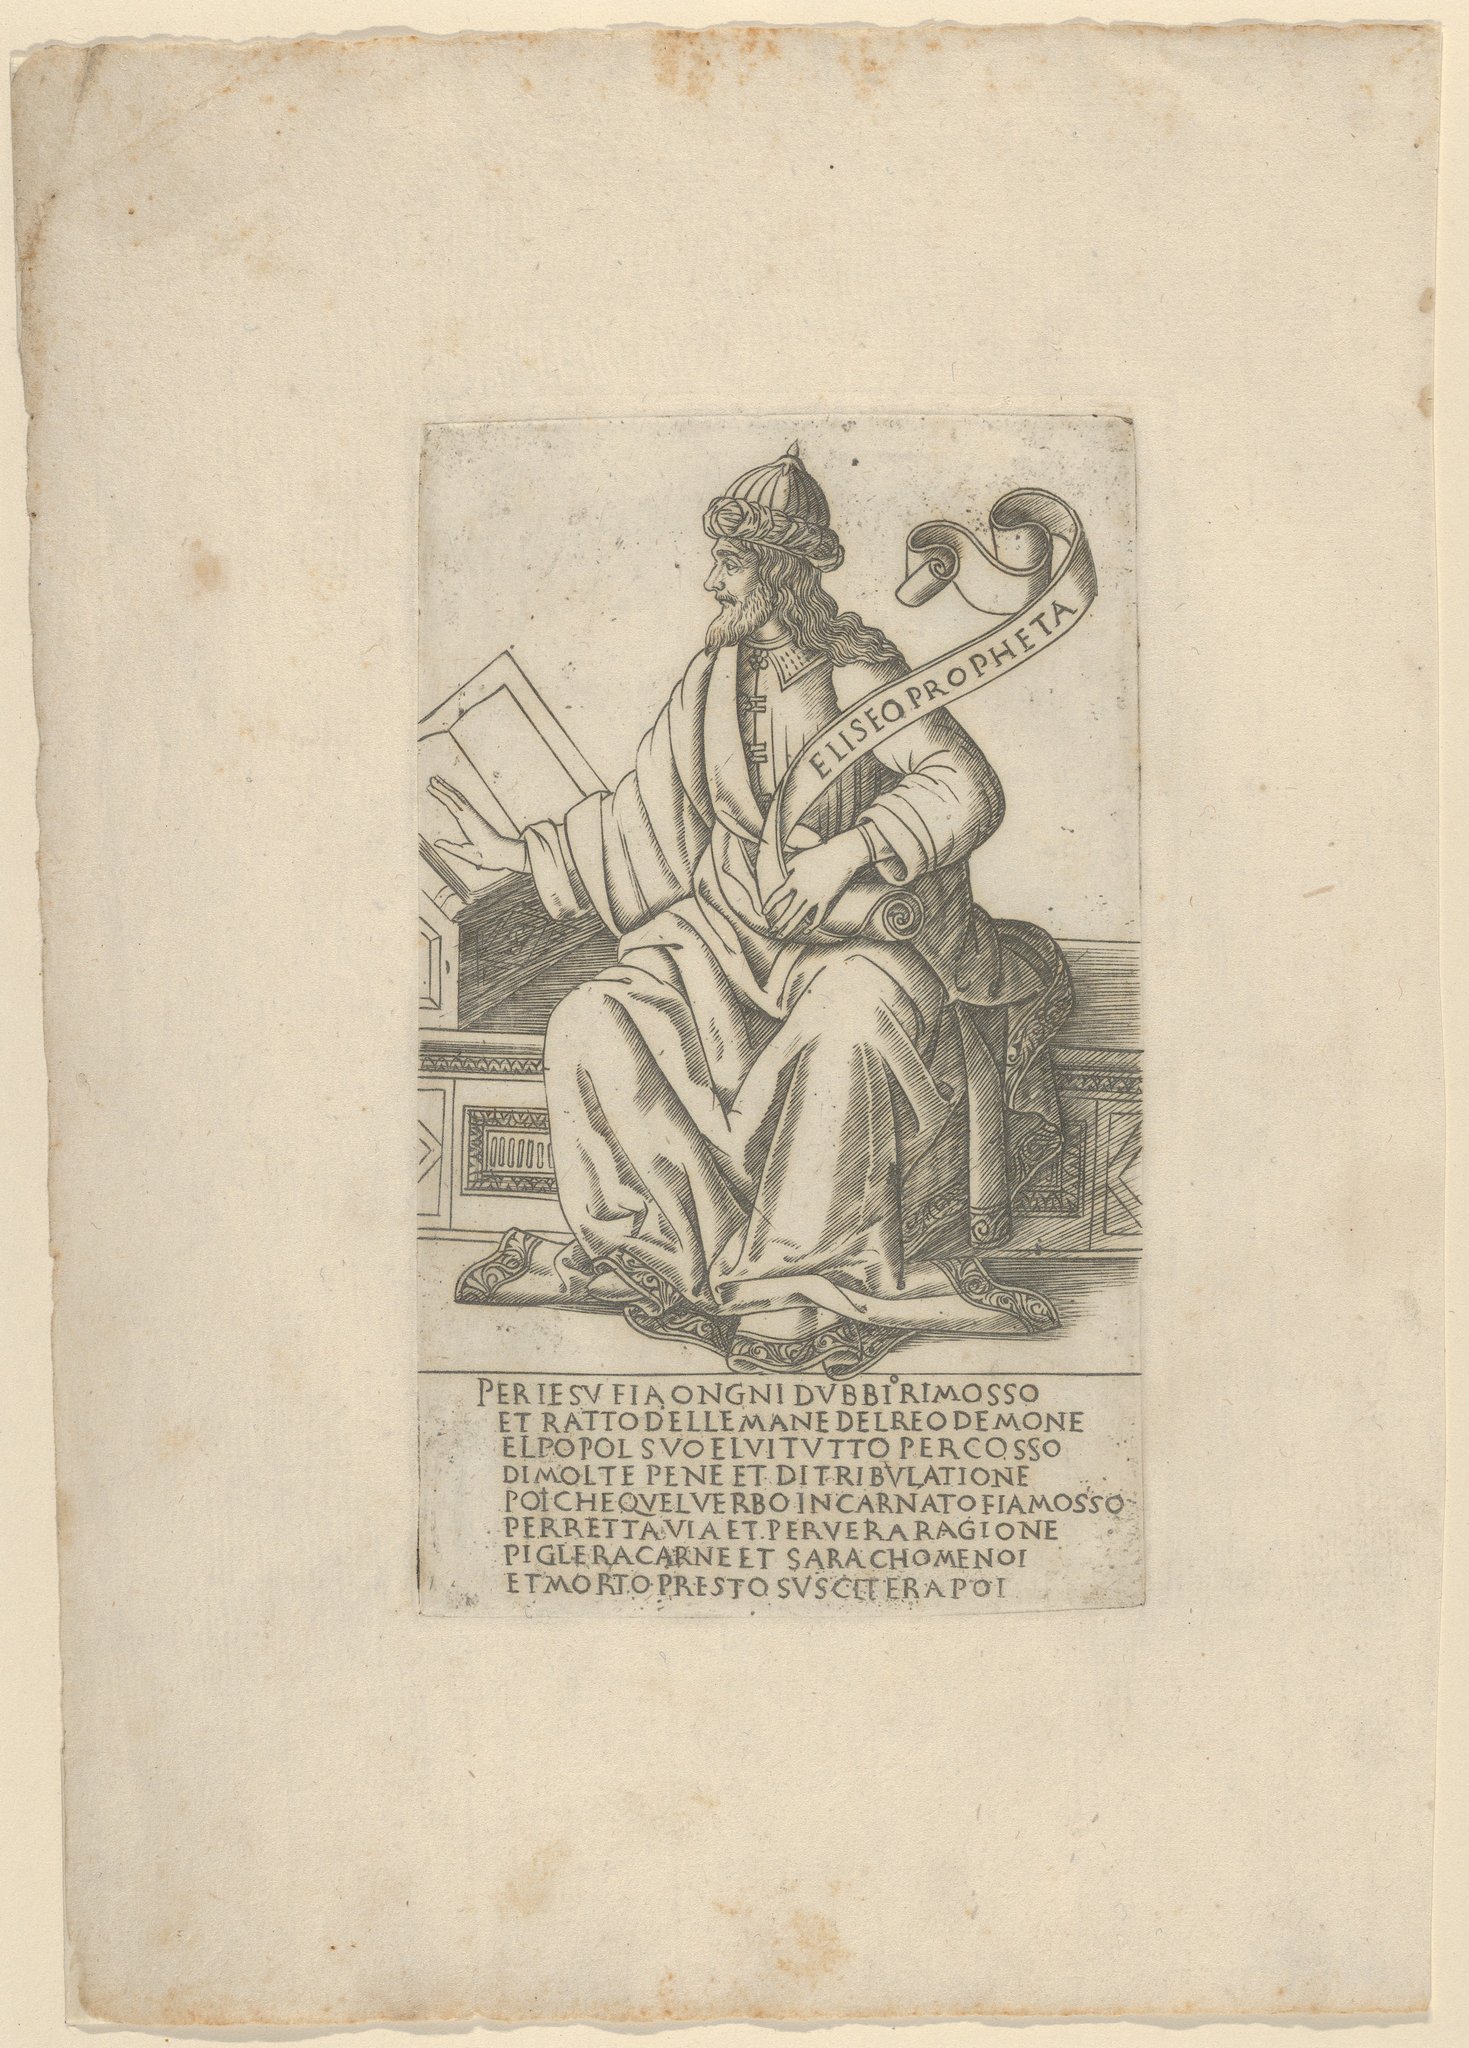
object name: print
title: The Prophet Elisha, from Prophets and Sibyls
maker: francesco rosselli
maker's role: artist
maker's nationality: italian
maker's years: 1448-1527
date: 1480-1490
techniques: engraving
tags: men